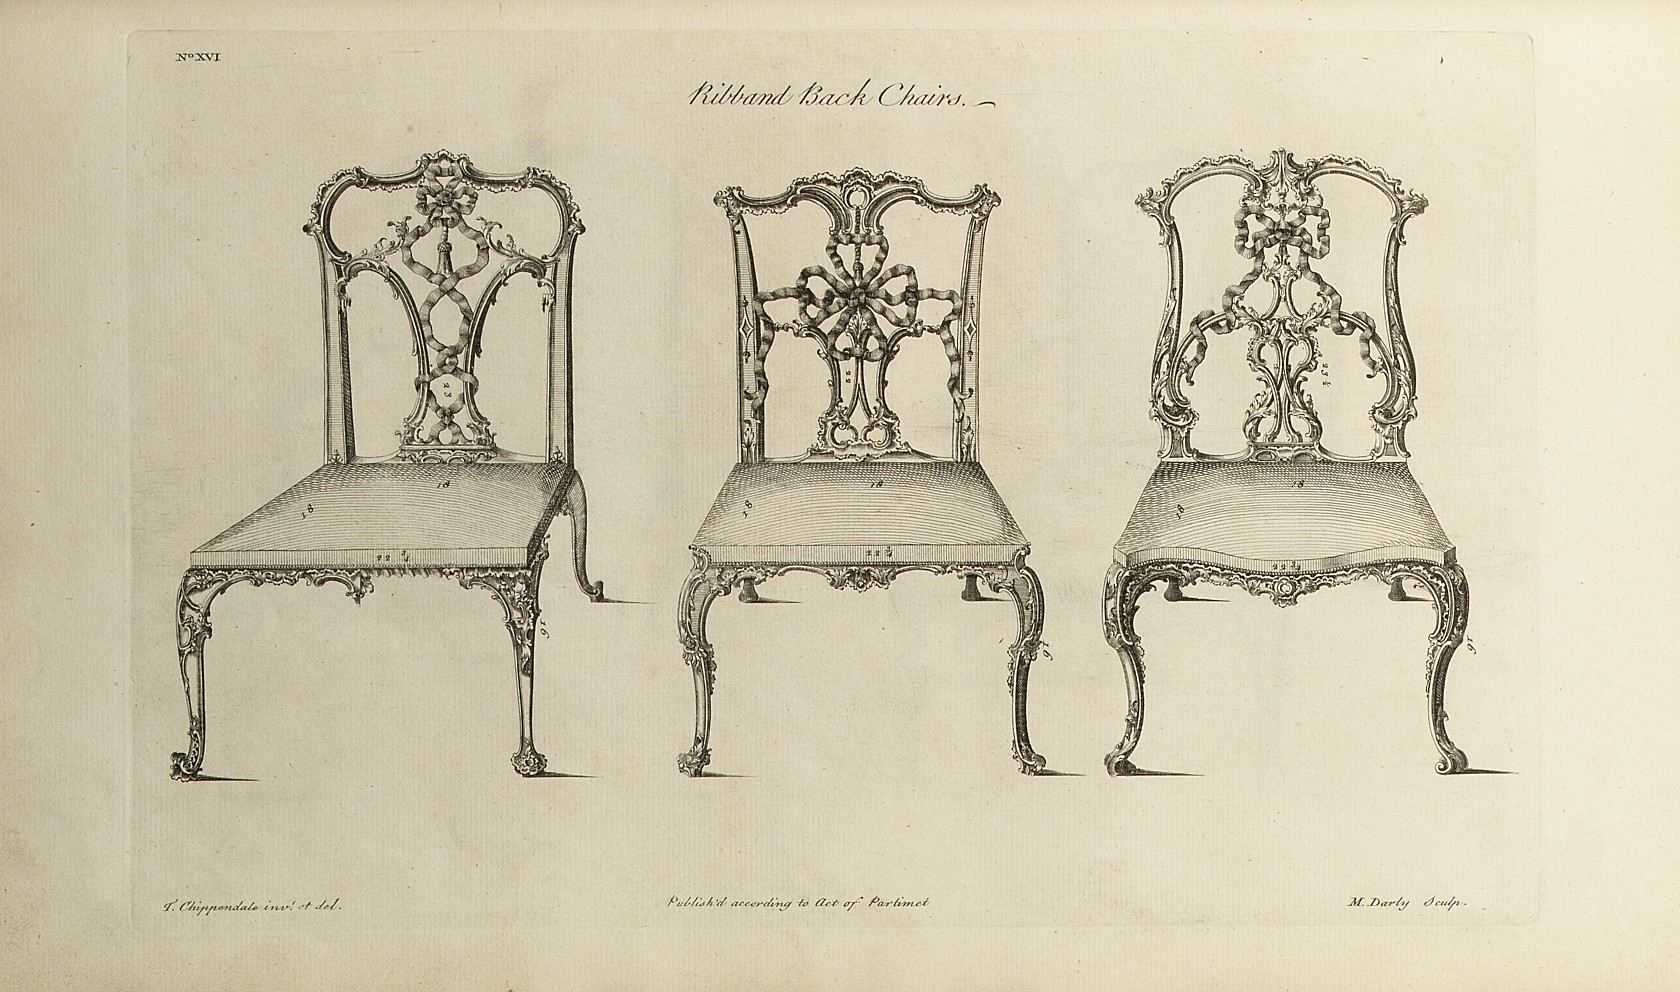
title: The Gentleman and Cabinet-maker's Director: Being a Large Collection of . . . Designs of Household Furniture in the Gothic, Chinese and Modern Taste . . .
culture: british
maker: thomas chippendale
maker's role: author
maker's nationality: british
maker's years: 1718-1779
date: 1754